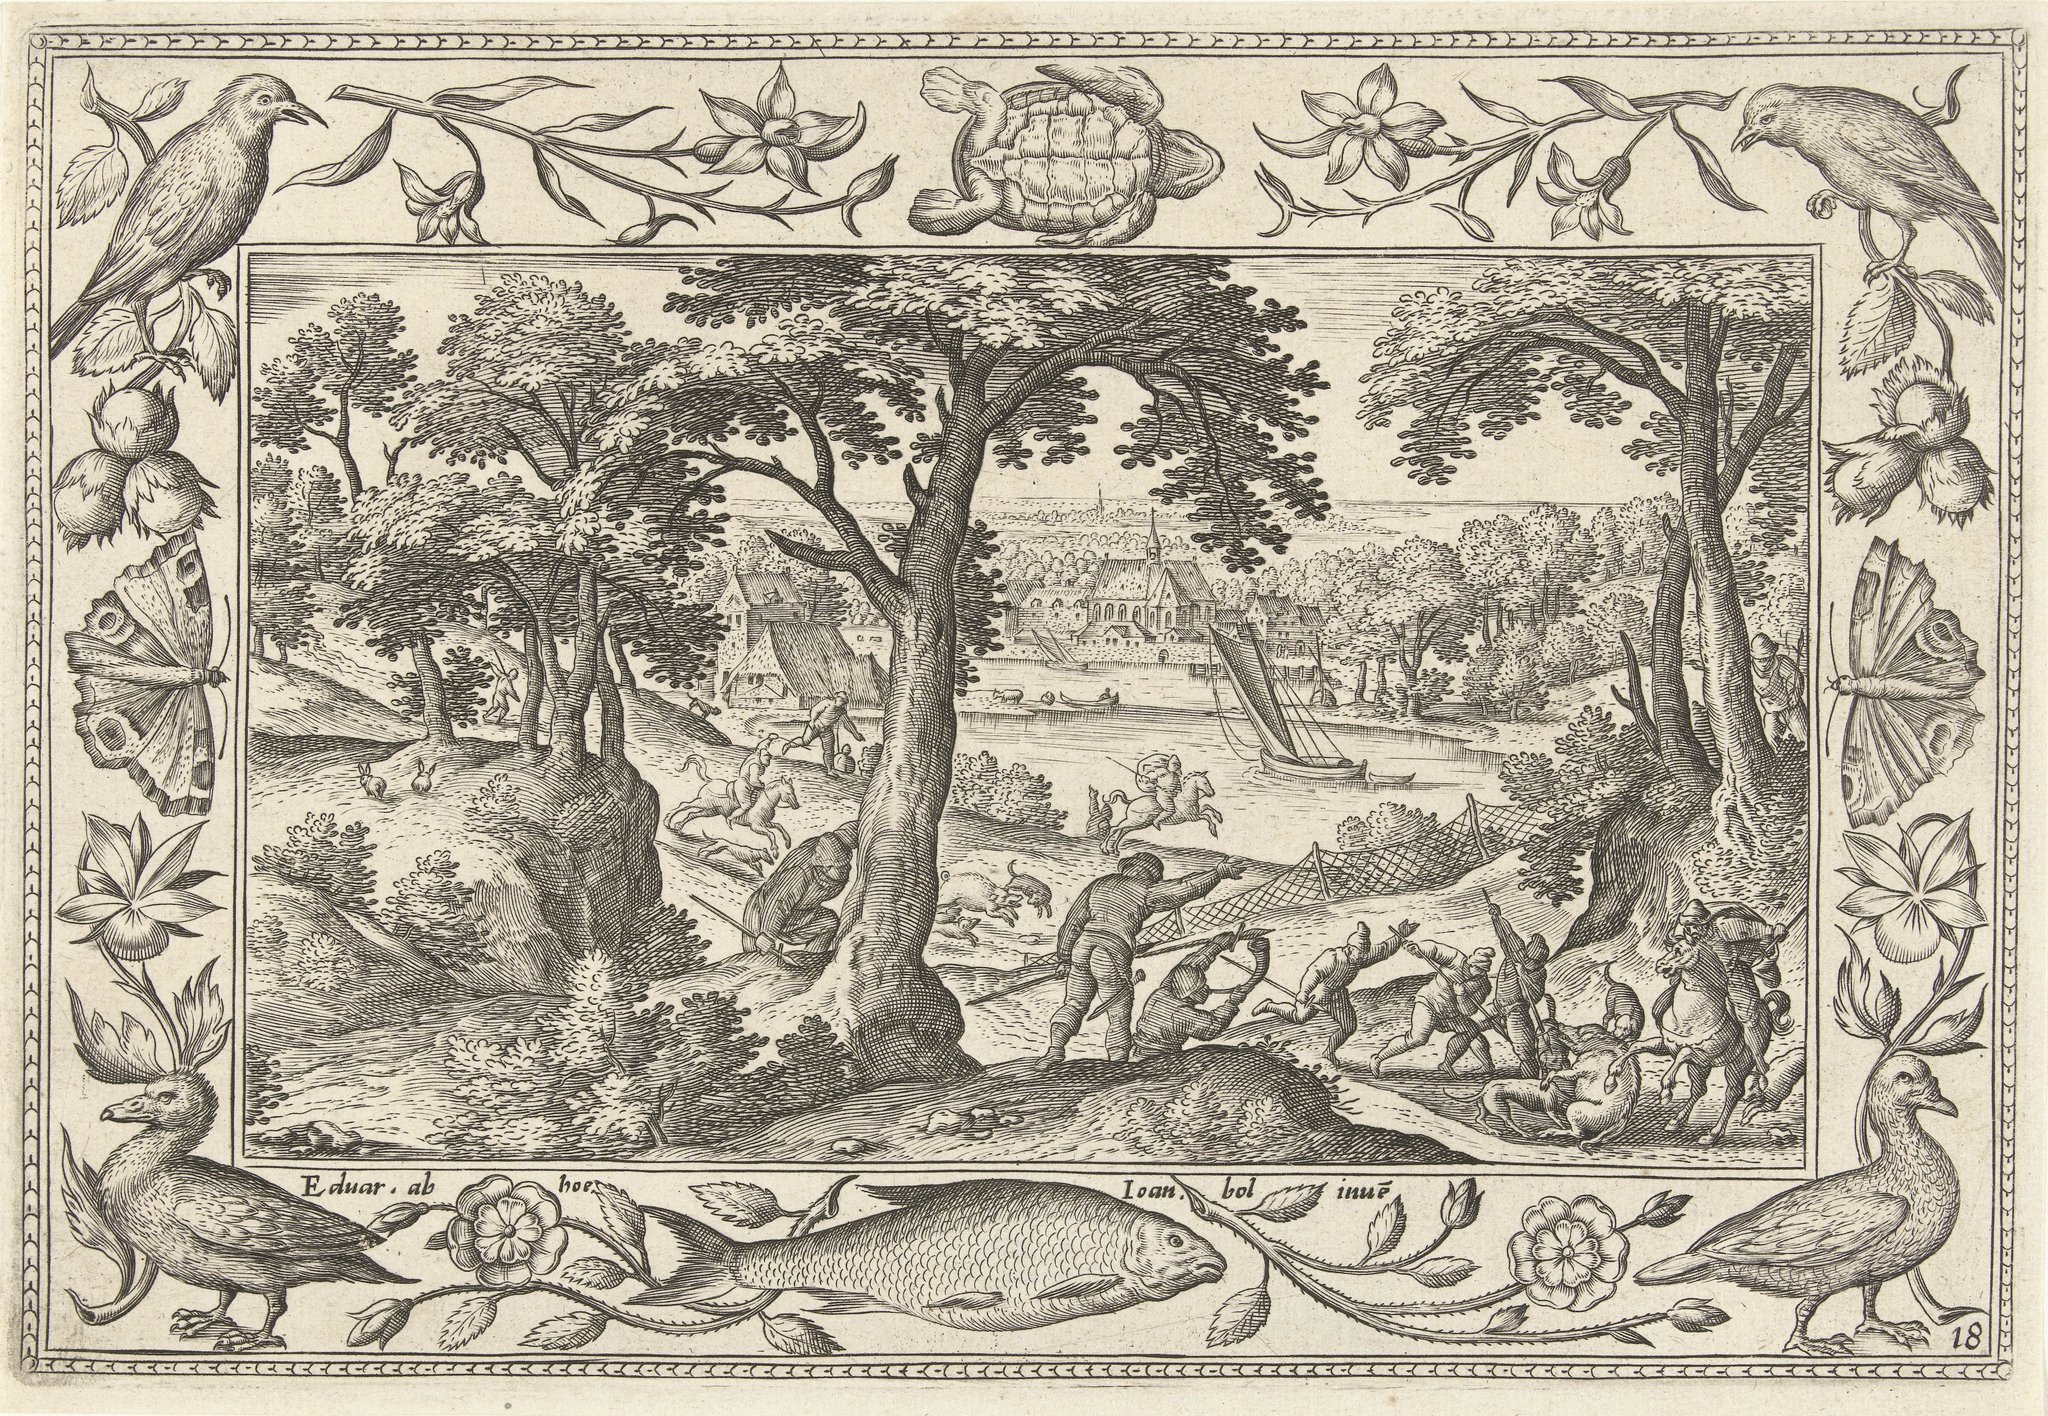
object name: print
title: Zwijnenjacht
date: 1582-1586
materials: paper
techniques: engraving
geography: antwerp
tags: ornamental birds, boar-hunting, forest, wood, fishes (+ ornamental variants of animals), tortoises, turtles (+ ornamental variants of animals), flowers ~ ornament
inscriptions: collector's mark: Lugt 2228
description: Boslandschap met zwijnenjacht. Op de voorgrond wordt een everzwijn door honden belaagd en door jagers neergestoken. De prent heeft een ornamentele lijst met bloemen en dieren. Hij maakt deel uit van een vierentwintigdelige serie van landschappen met Bijbelse, mythologische scènes en jachttaferelen.